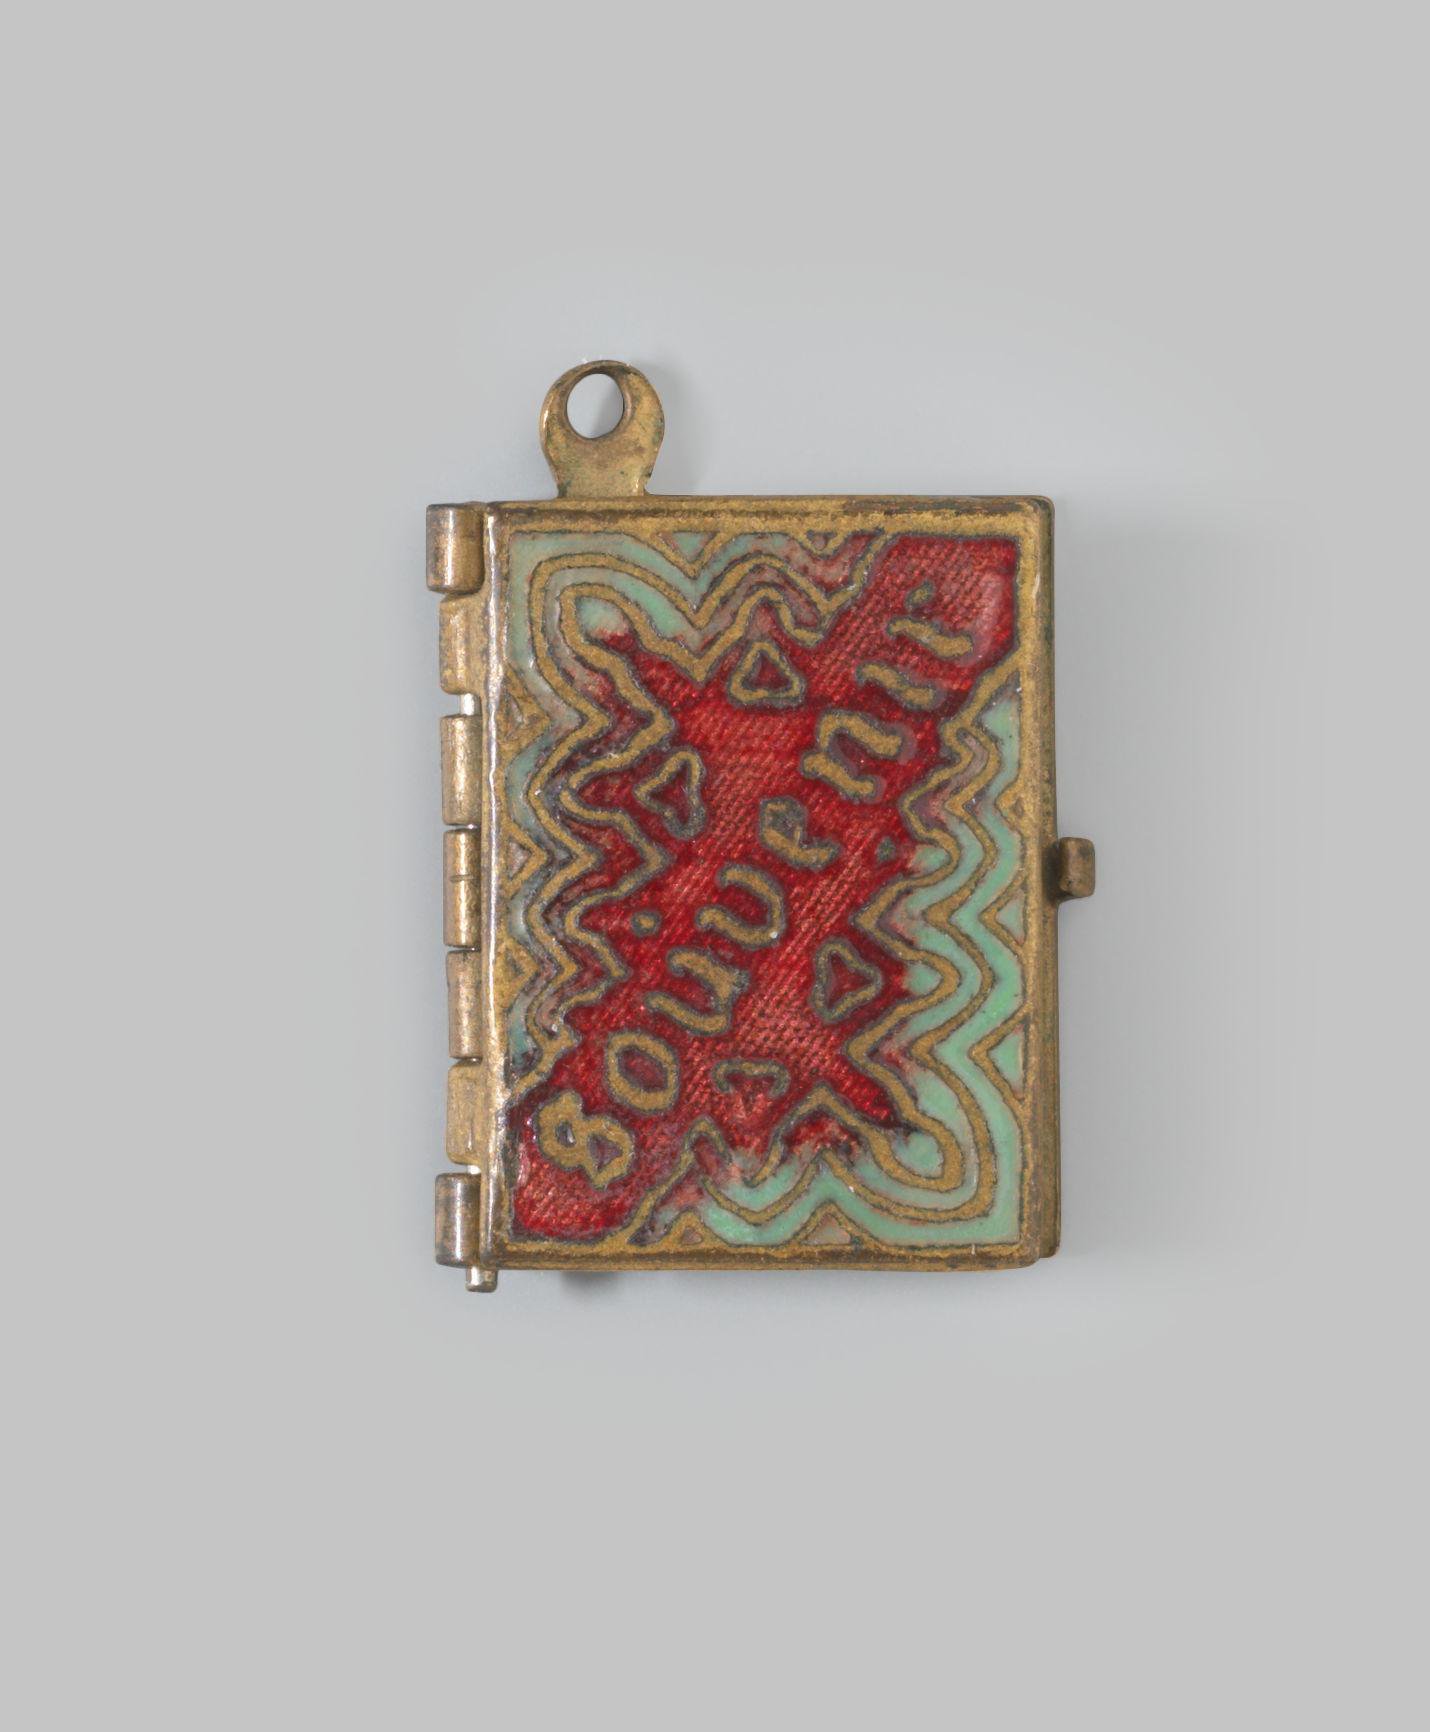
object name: photograph album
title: Hanger met miniatuur fotoalbum met vijf Amsterdamse stadsgezichten, souvenir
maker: Anonymous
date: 1900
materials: paper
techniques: photography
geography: amsterdam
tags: amsterdam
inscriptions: : ‘.’